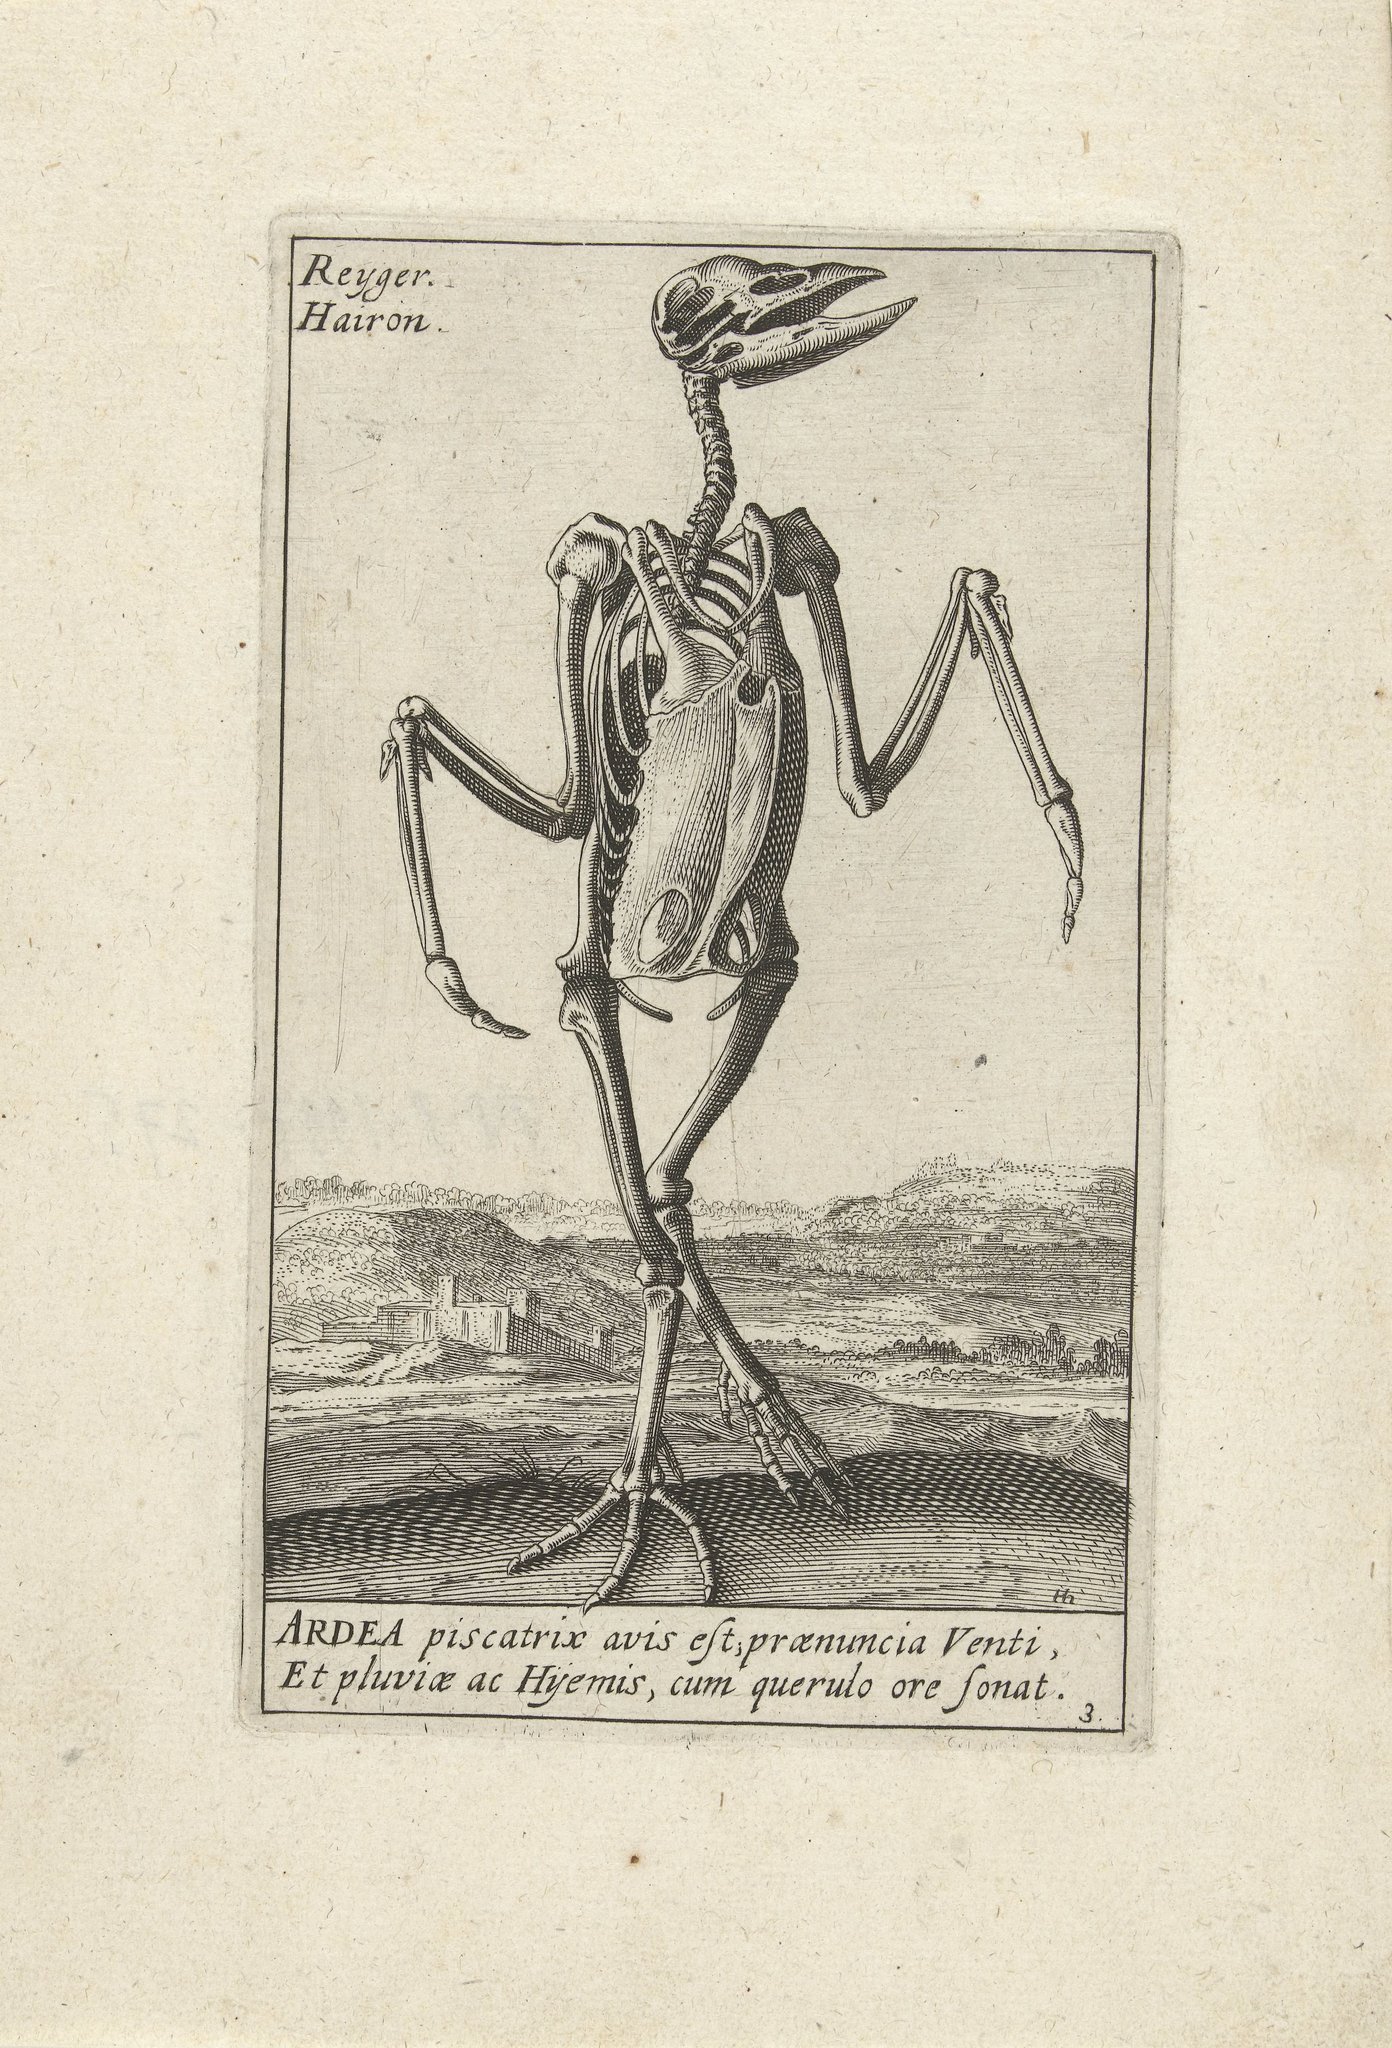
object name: print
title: Skelet van een reiger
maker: hendrick hondius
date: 1626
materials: paper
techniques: engraving, etching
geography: the hague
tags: animals (+ skeleton of an animal), shore-birds and wading-birds: heron (+ skeleton of an animal)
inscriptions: collector's mark: Lugt 2228, signature and date: ‘r.o. Hh fec.’, inscription: ‘l.b.: Reyger / Haiton; m.o. in kader: ARDEA piscatrix avis est, proenuncia Venti, Et pluviae ac Hyemis, cum querulo ora sonat. r.o.: 3’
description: Skelet van een staande reiger, van voren gezien. Onder de voorstelling twee regels in het Latijn. Prent uit een serie met voorstellingen van skeletten door de prentmakers Hendrick Hondius I (NewHollst.243-258), Andries Jacobsz. Stock (Hollst.4-10) en Simon Frisius.